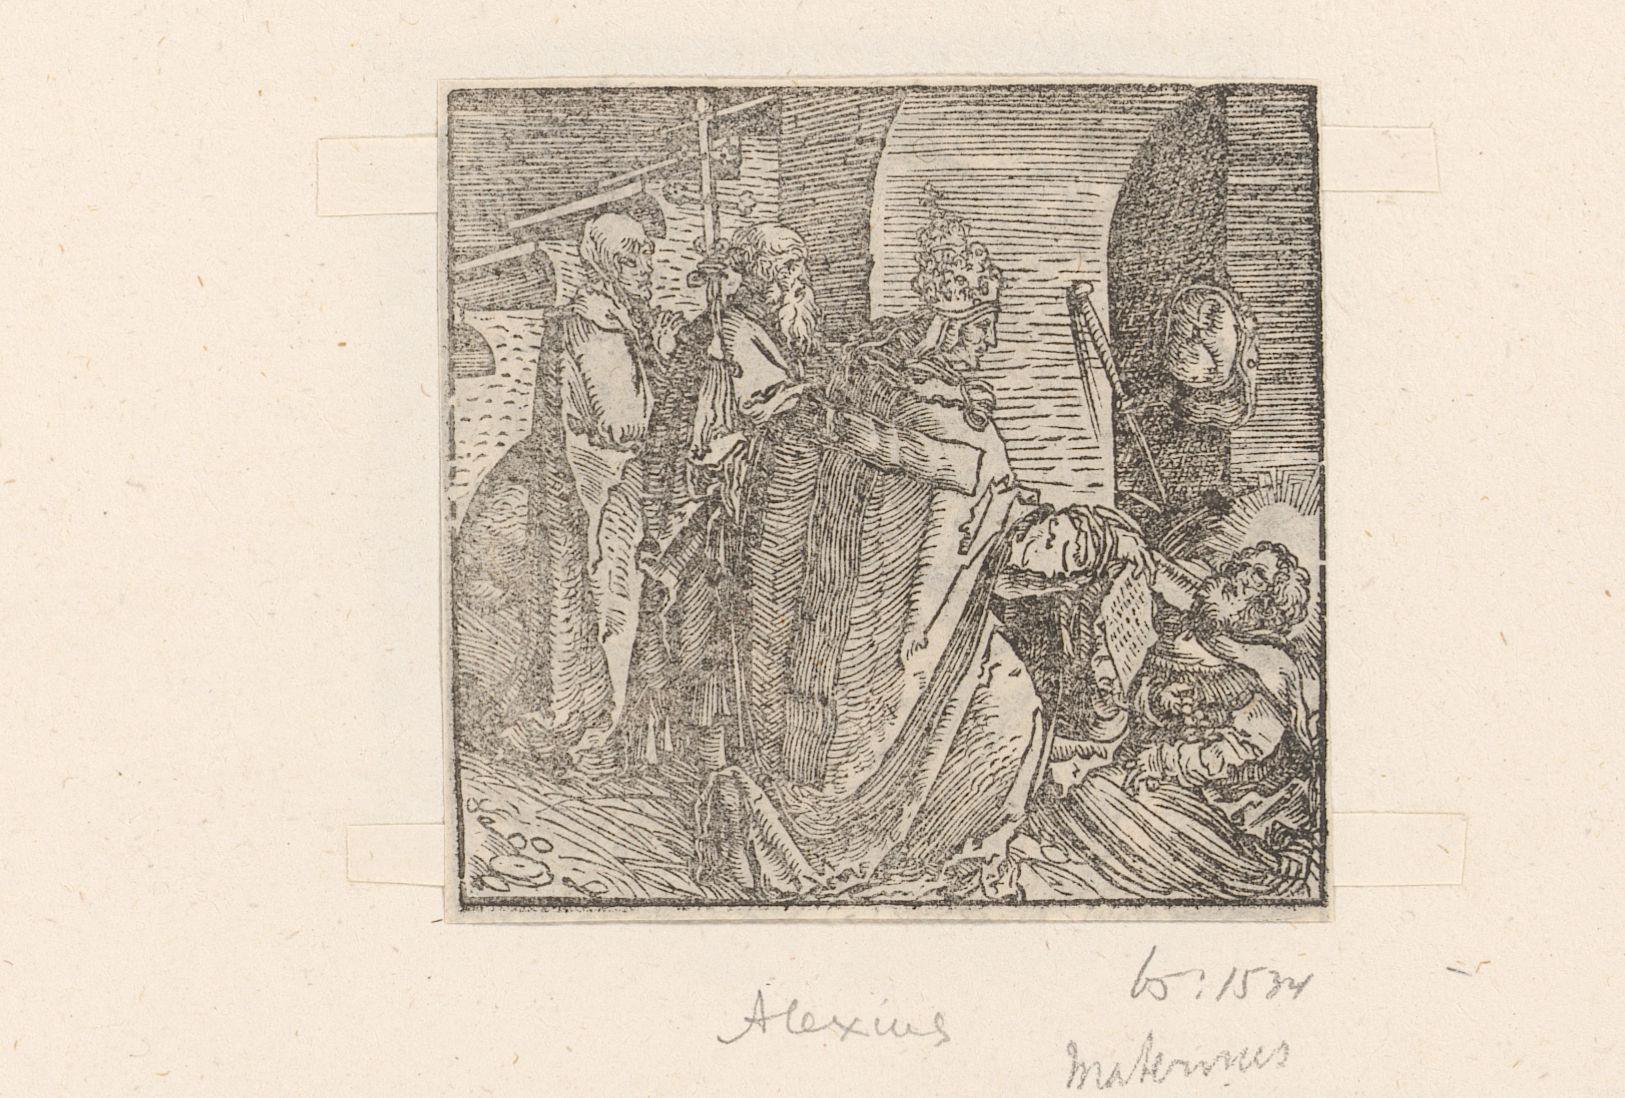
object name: album leaf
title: H. Alexis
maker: Anonymous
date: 1500-1536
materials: paper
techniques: woodcut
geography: germany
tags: the confessor alexi(u)s of rome (or edessa); possible attributes: staircase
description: Een kerkelijke hoogwaardigheidsbekleder brengt een oorkonde naar de Heilige Alexis die op de grond zit. Prent maakt deel uit van een album.